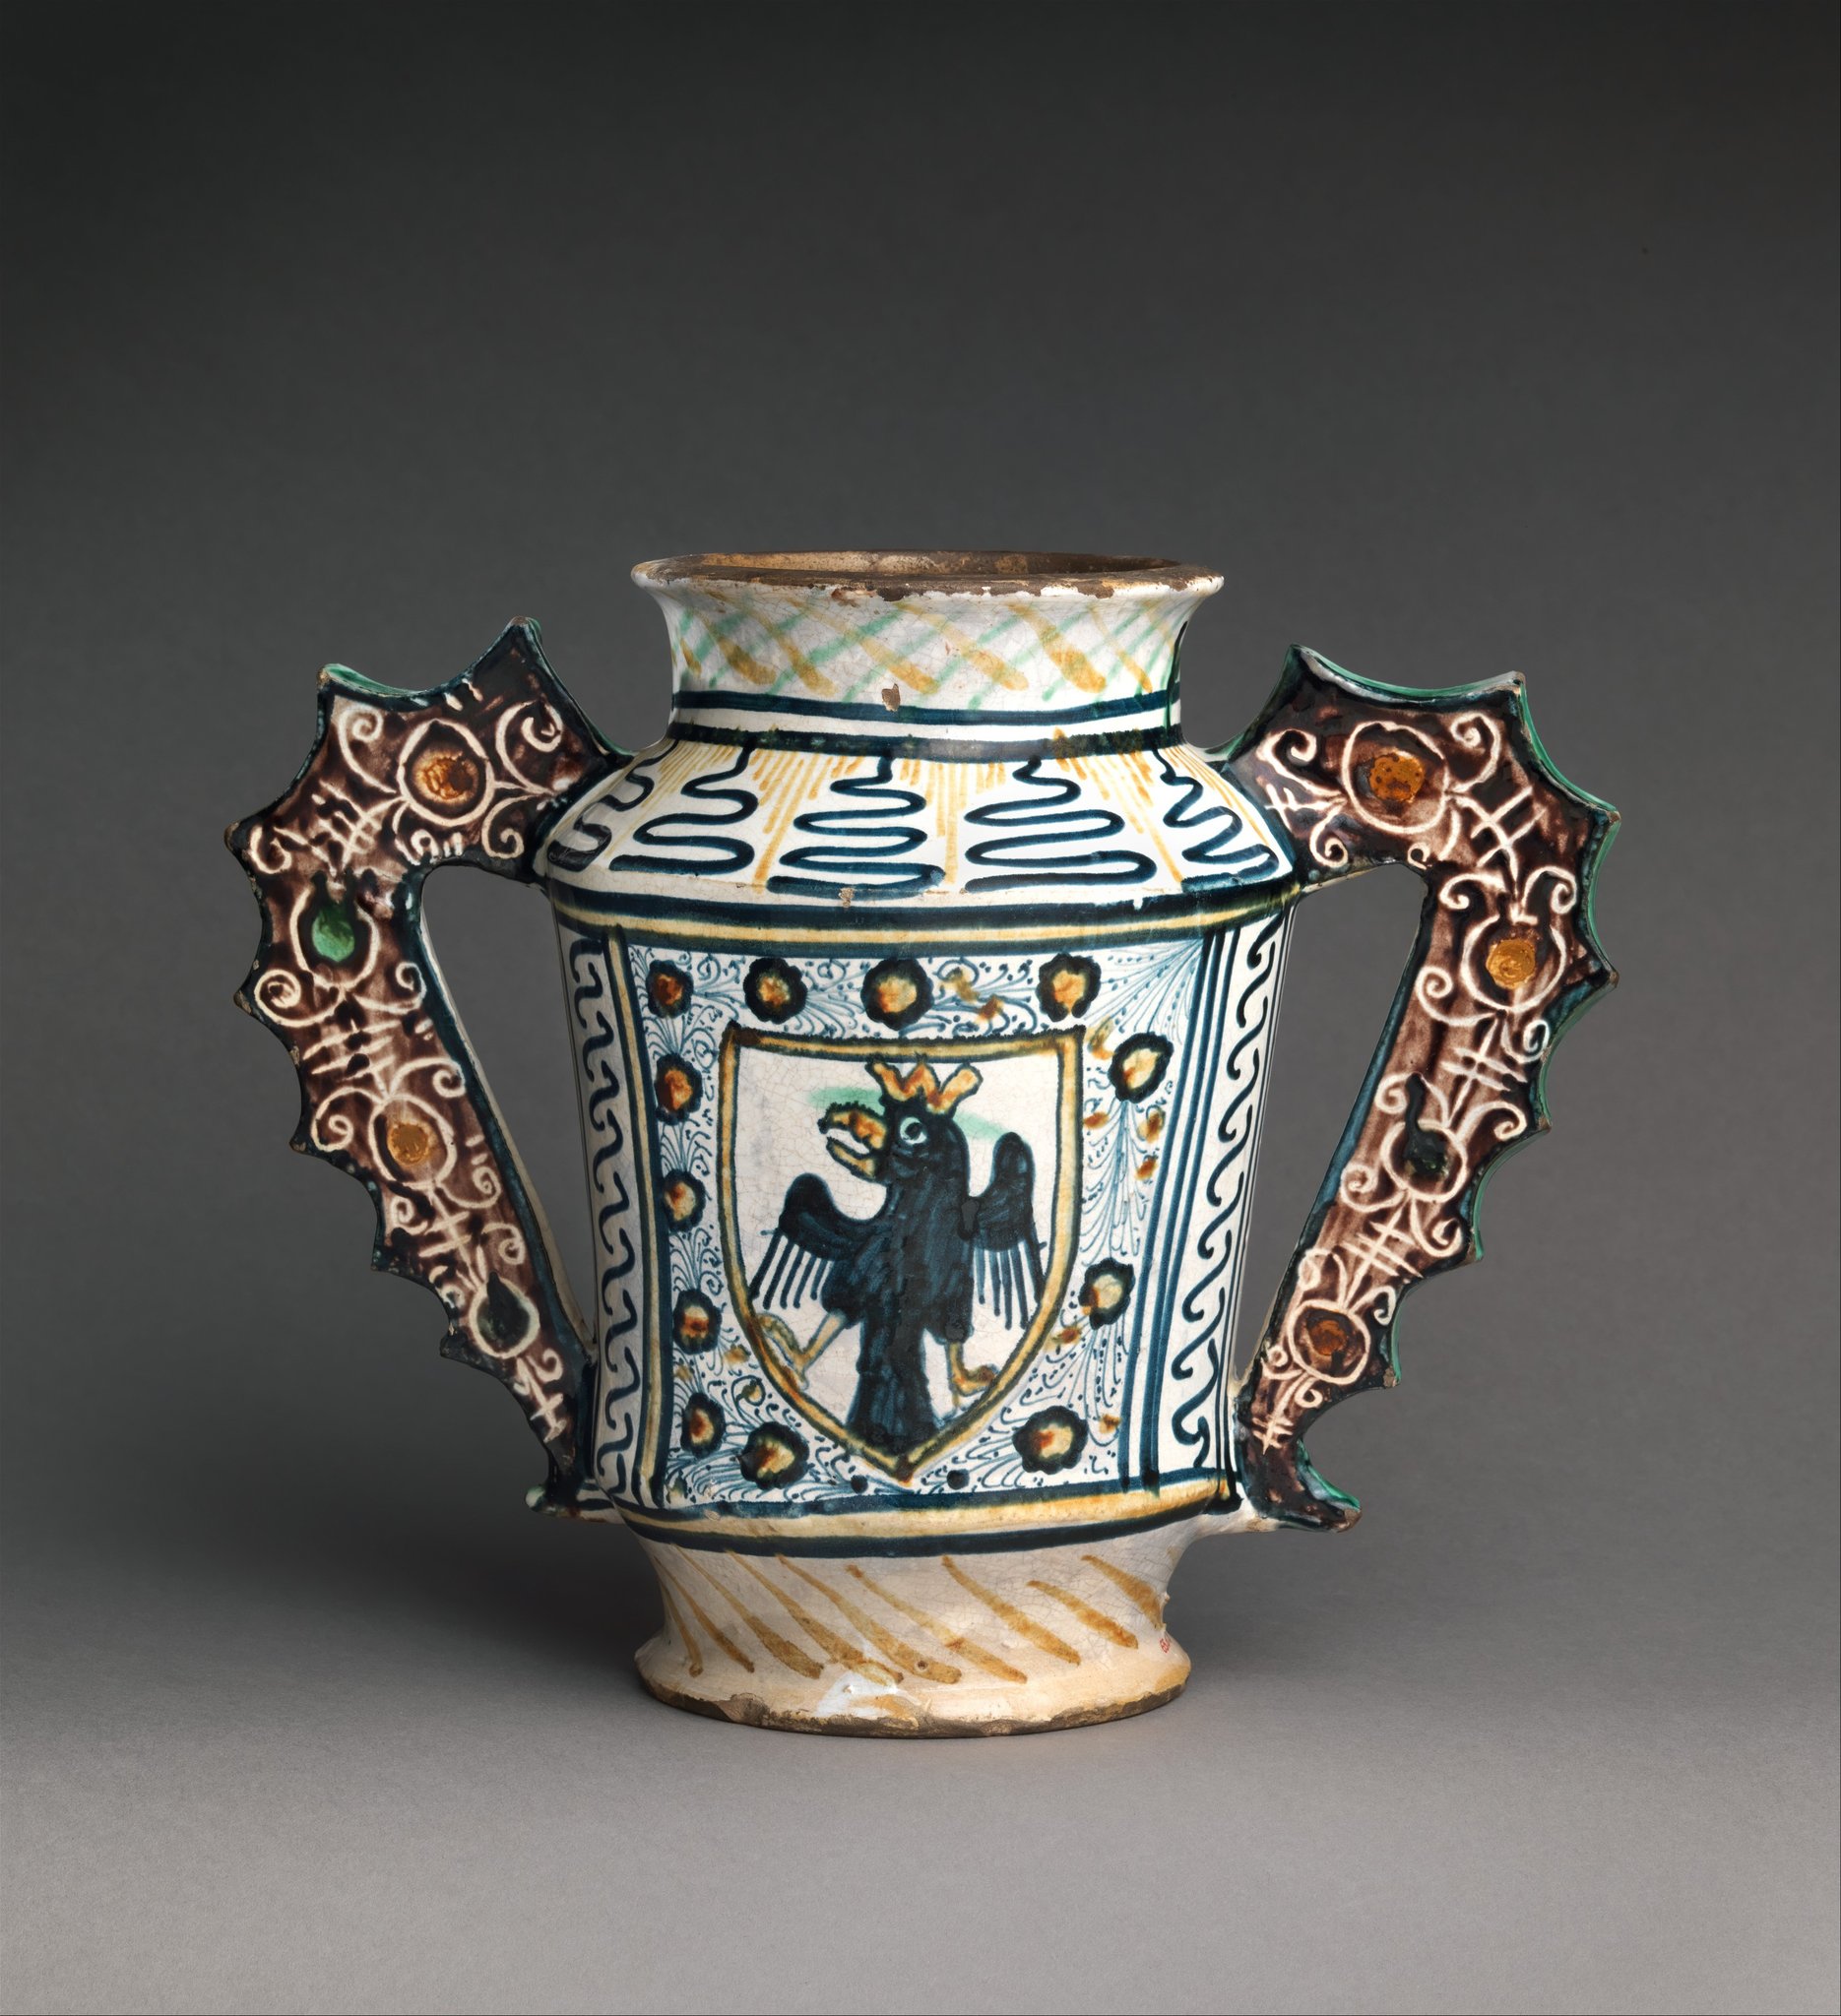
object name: vase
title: Two-handled storage jug (albarello) with crowned eagles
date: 1460-1480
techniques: maiolica, glazing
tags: eagles